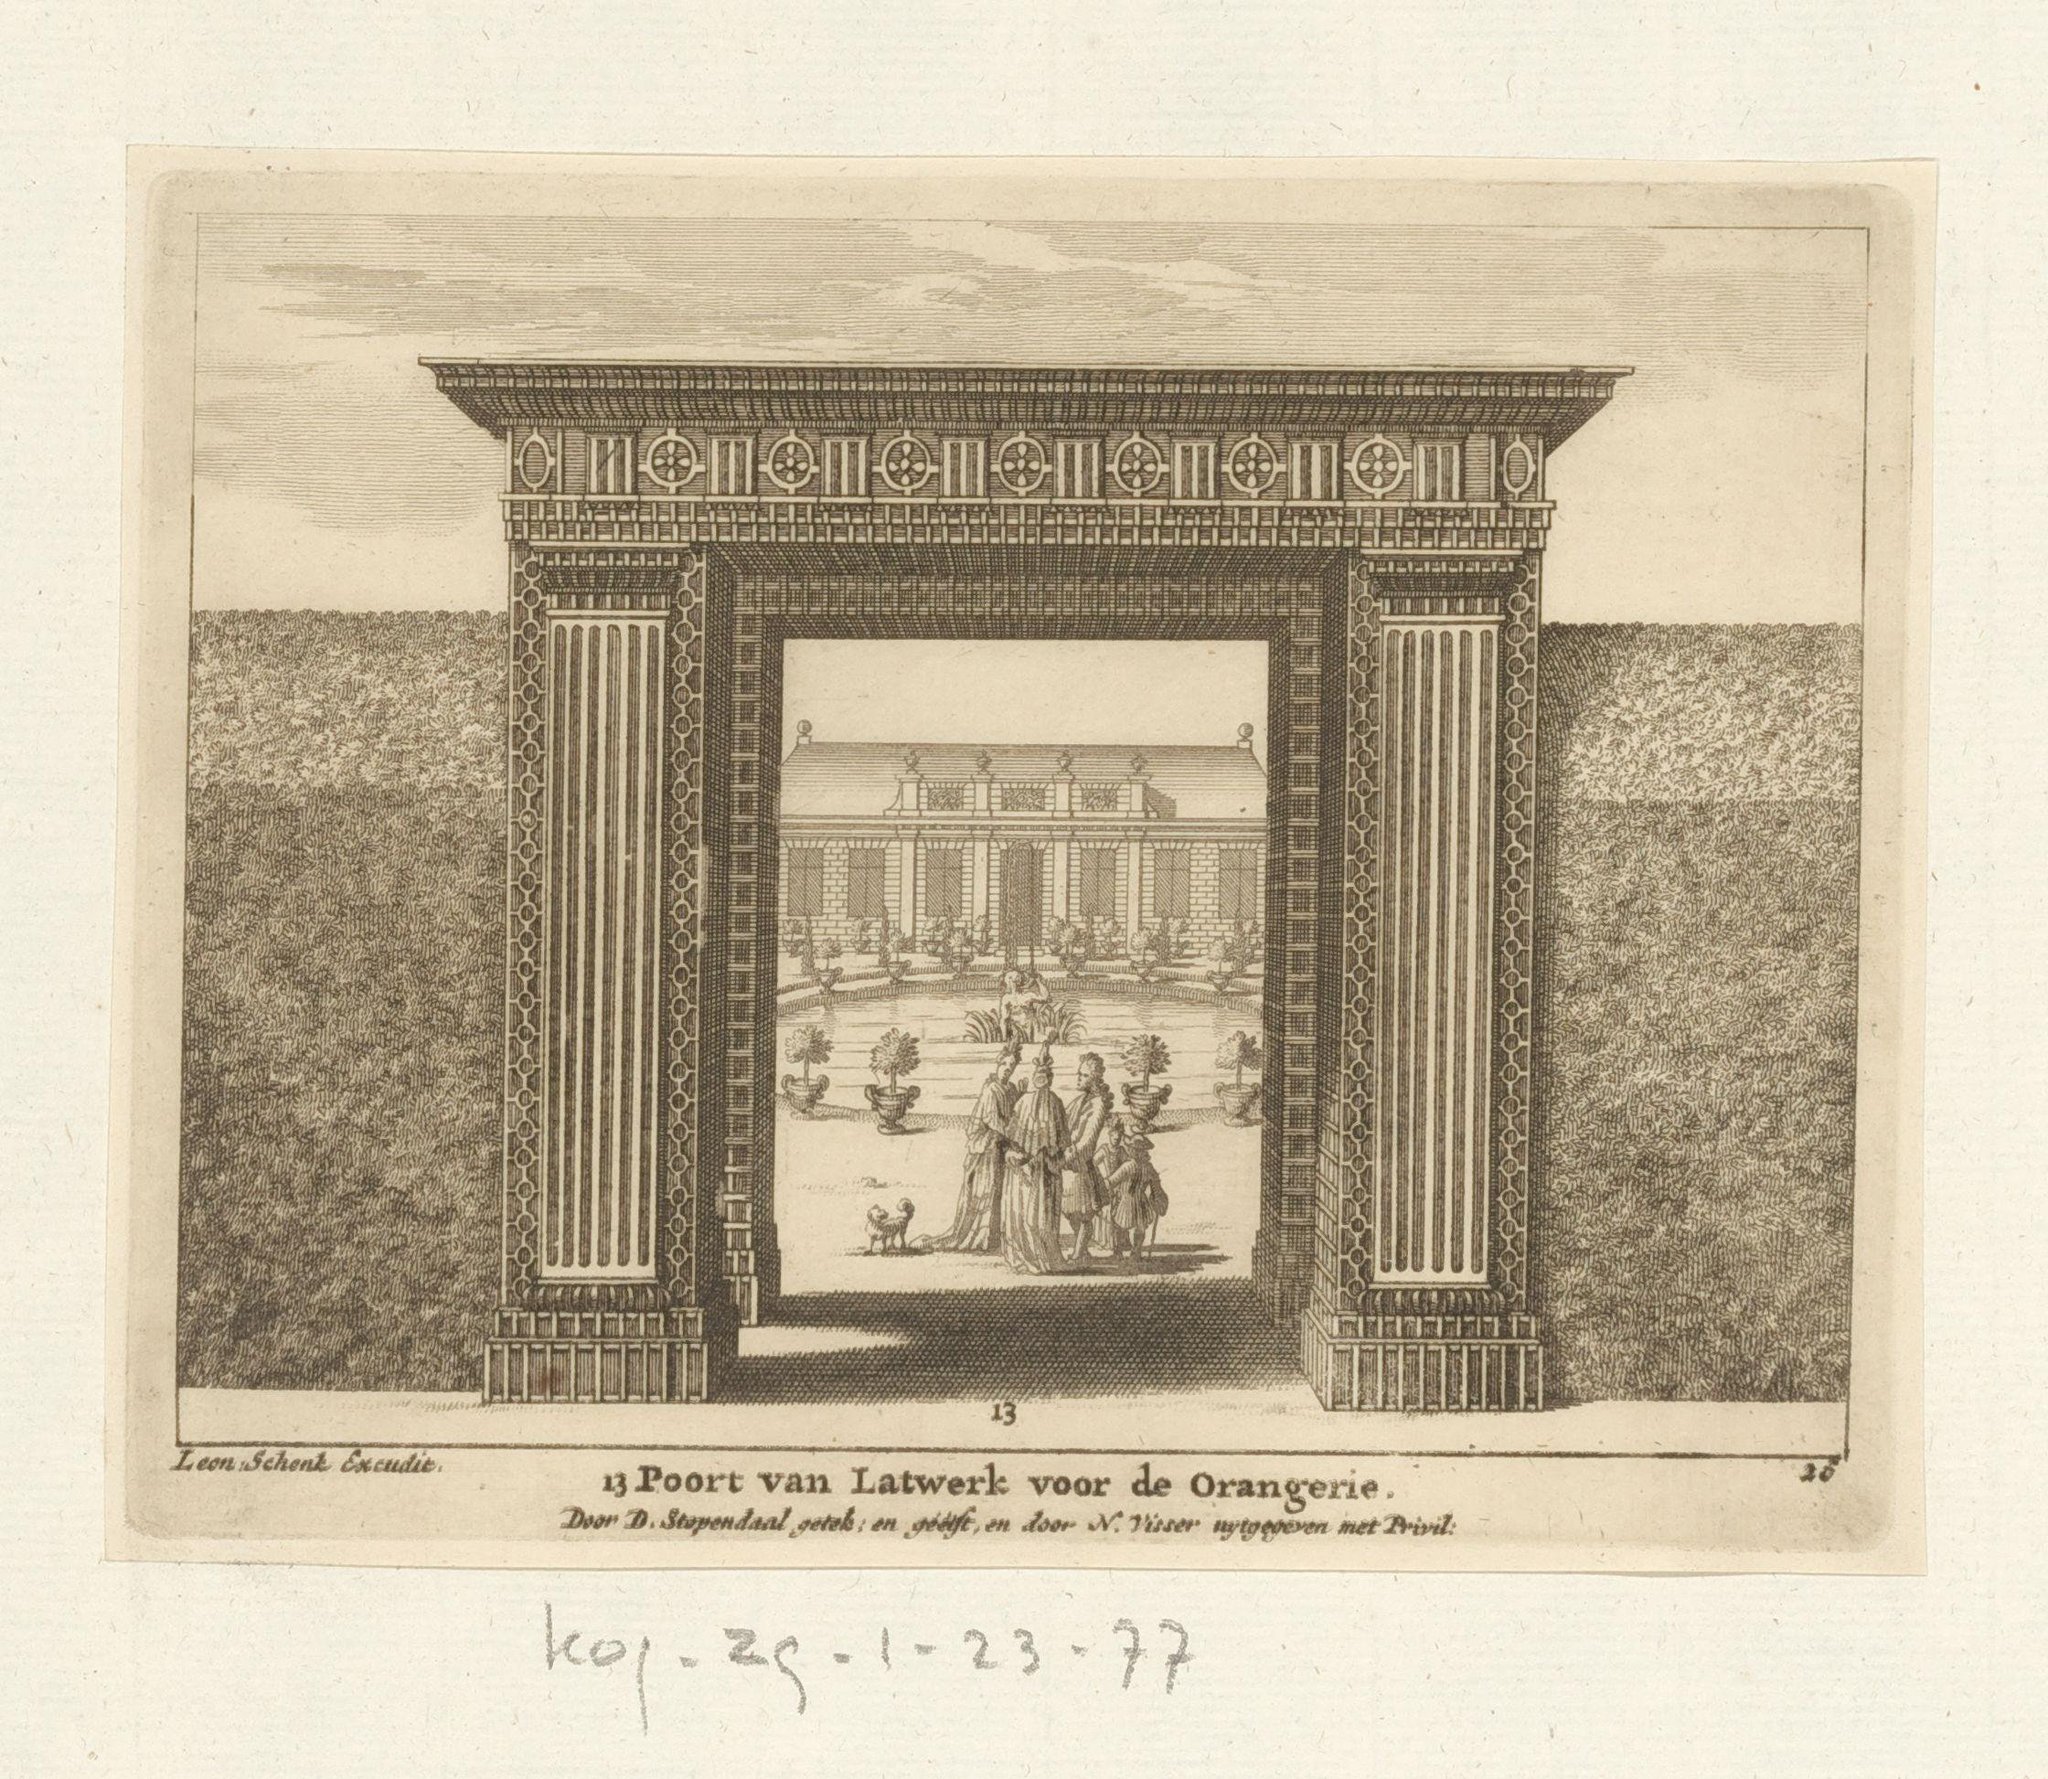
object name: print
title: Verscheyde schoone en vermaakelyke gezigten, in de Hofstede van Clingendaal gelegen by 's Gravenhage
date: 1706-1767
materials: paper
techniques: engraving, etching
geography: amsterdam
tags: french or architectonic garden; formal garden, greenhouse, orangery, garden pond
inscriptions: stamp, stamp, collector's mark: Lugt 1641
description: Op de voorgrond een houten poort met een doorkijk naar de vijver en de orangerie op landgoed Clingendael te Den Haag. Bij de poort een elegant gezelschap. Onderwerpsrubrieken binnen de Atlas Zeden en Gewoonten: Zeden en Gewoonten in Engeren Zin, De Woning. Kastelen en buitenplaatsen. Holland.